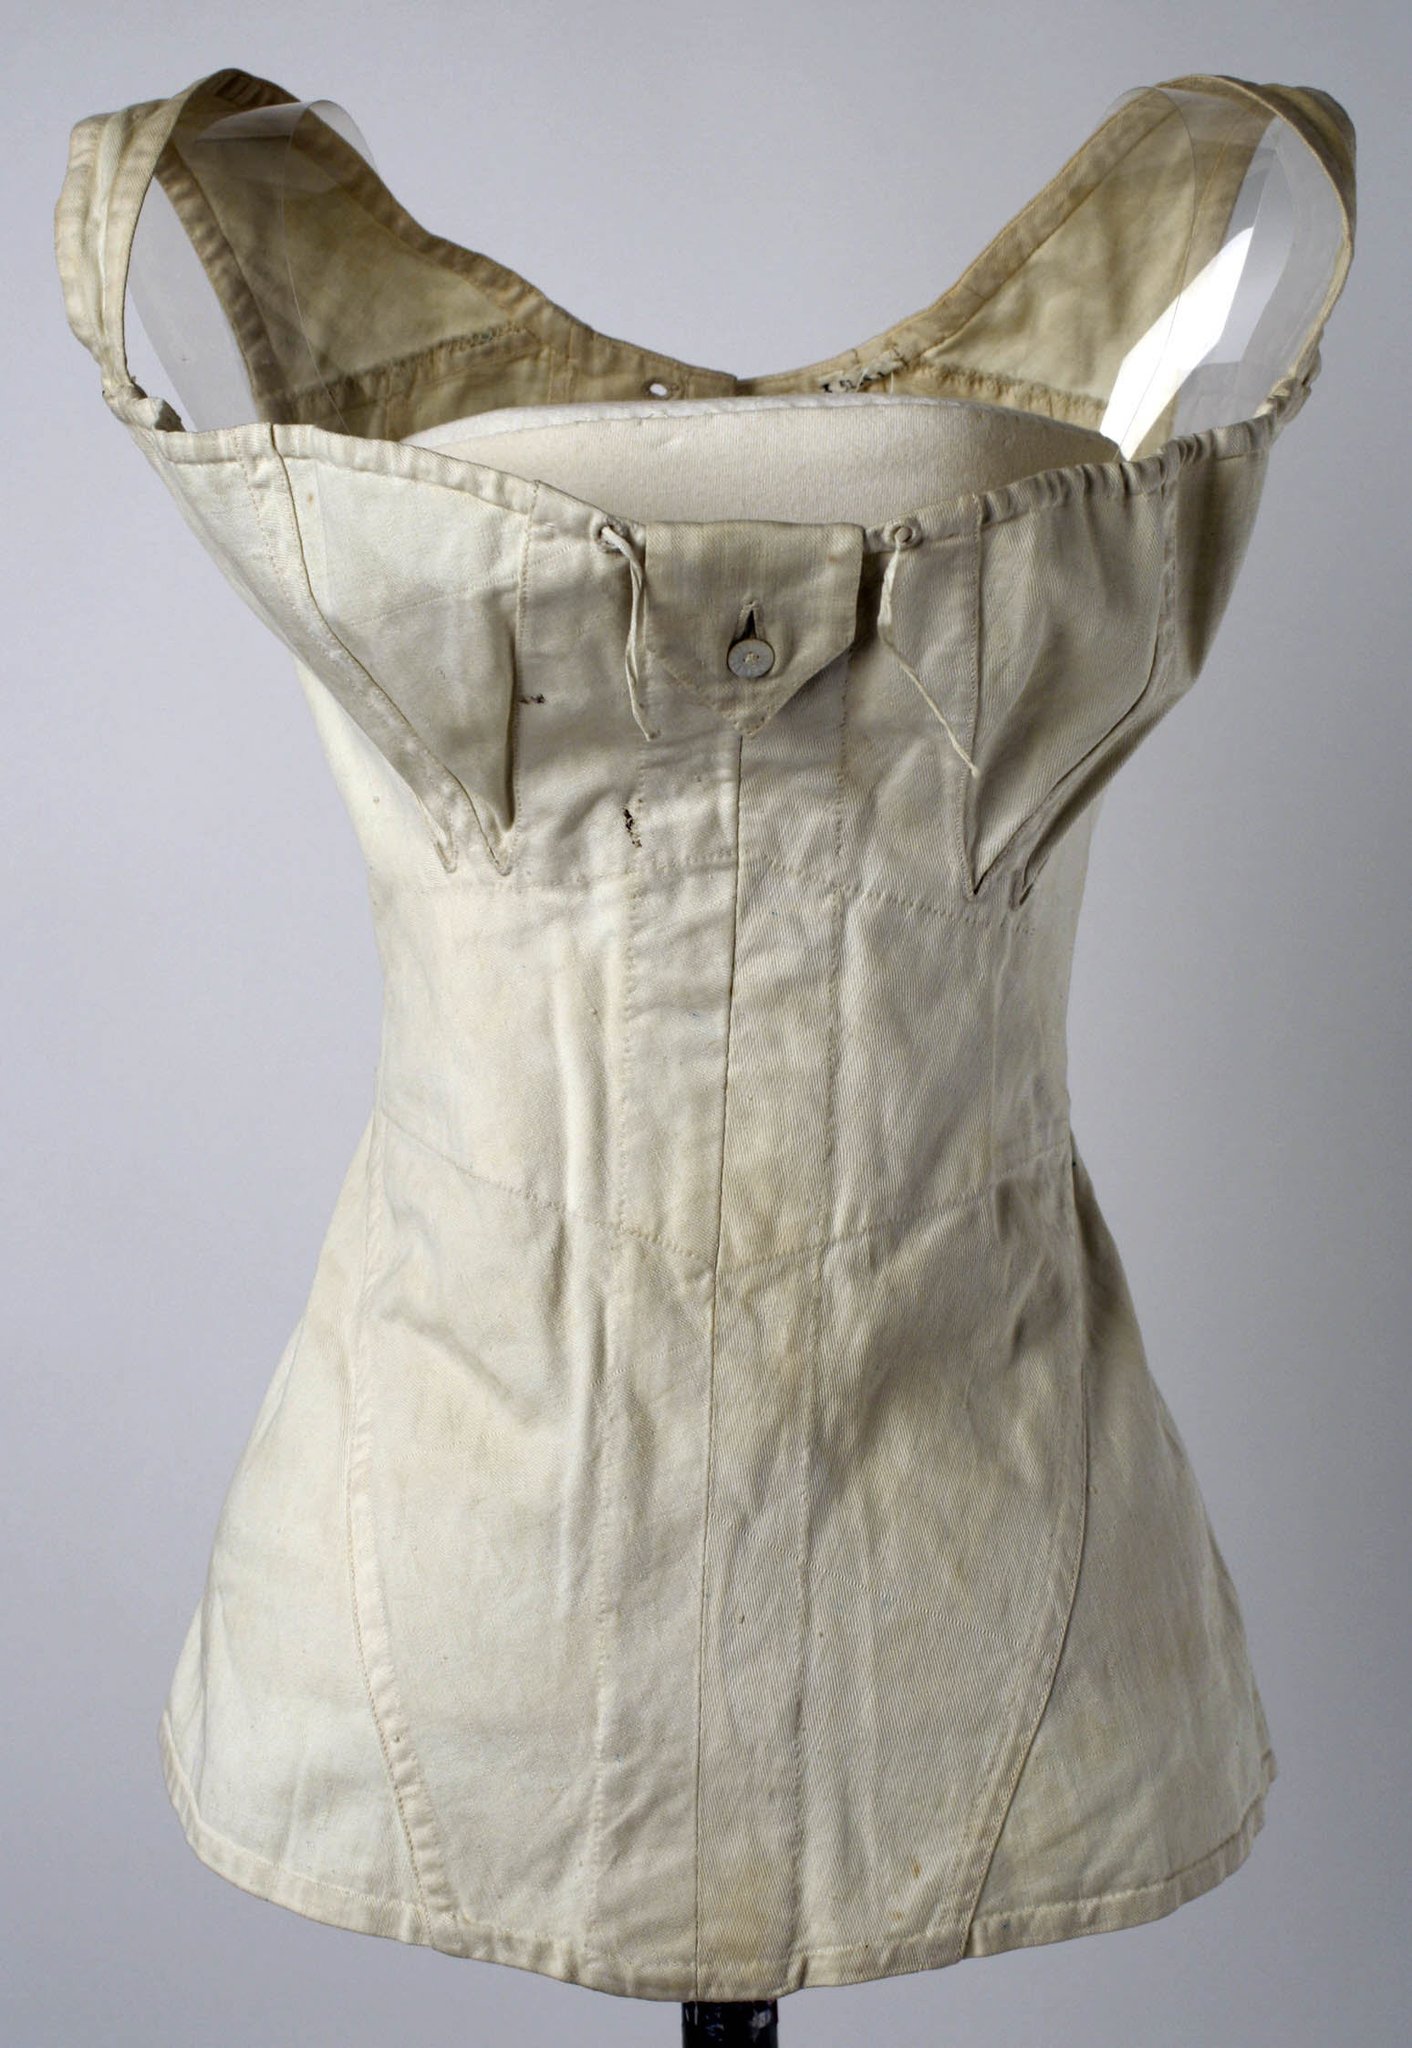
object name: corset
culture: american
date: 1811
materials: cotton